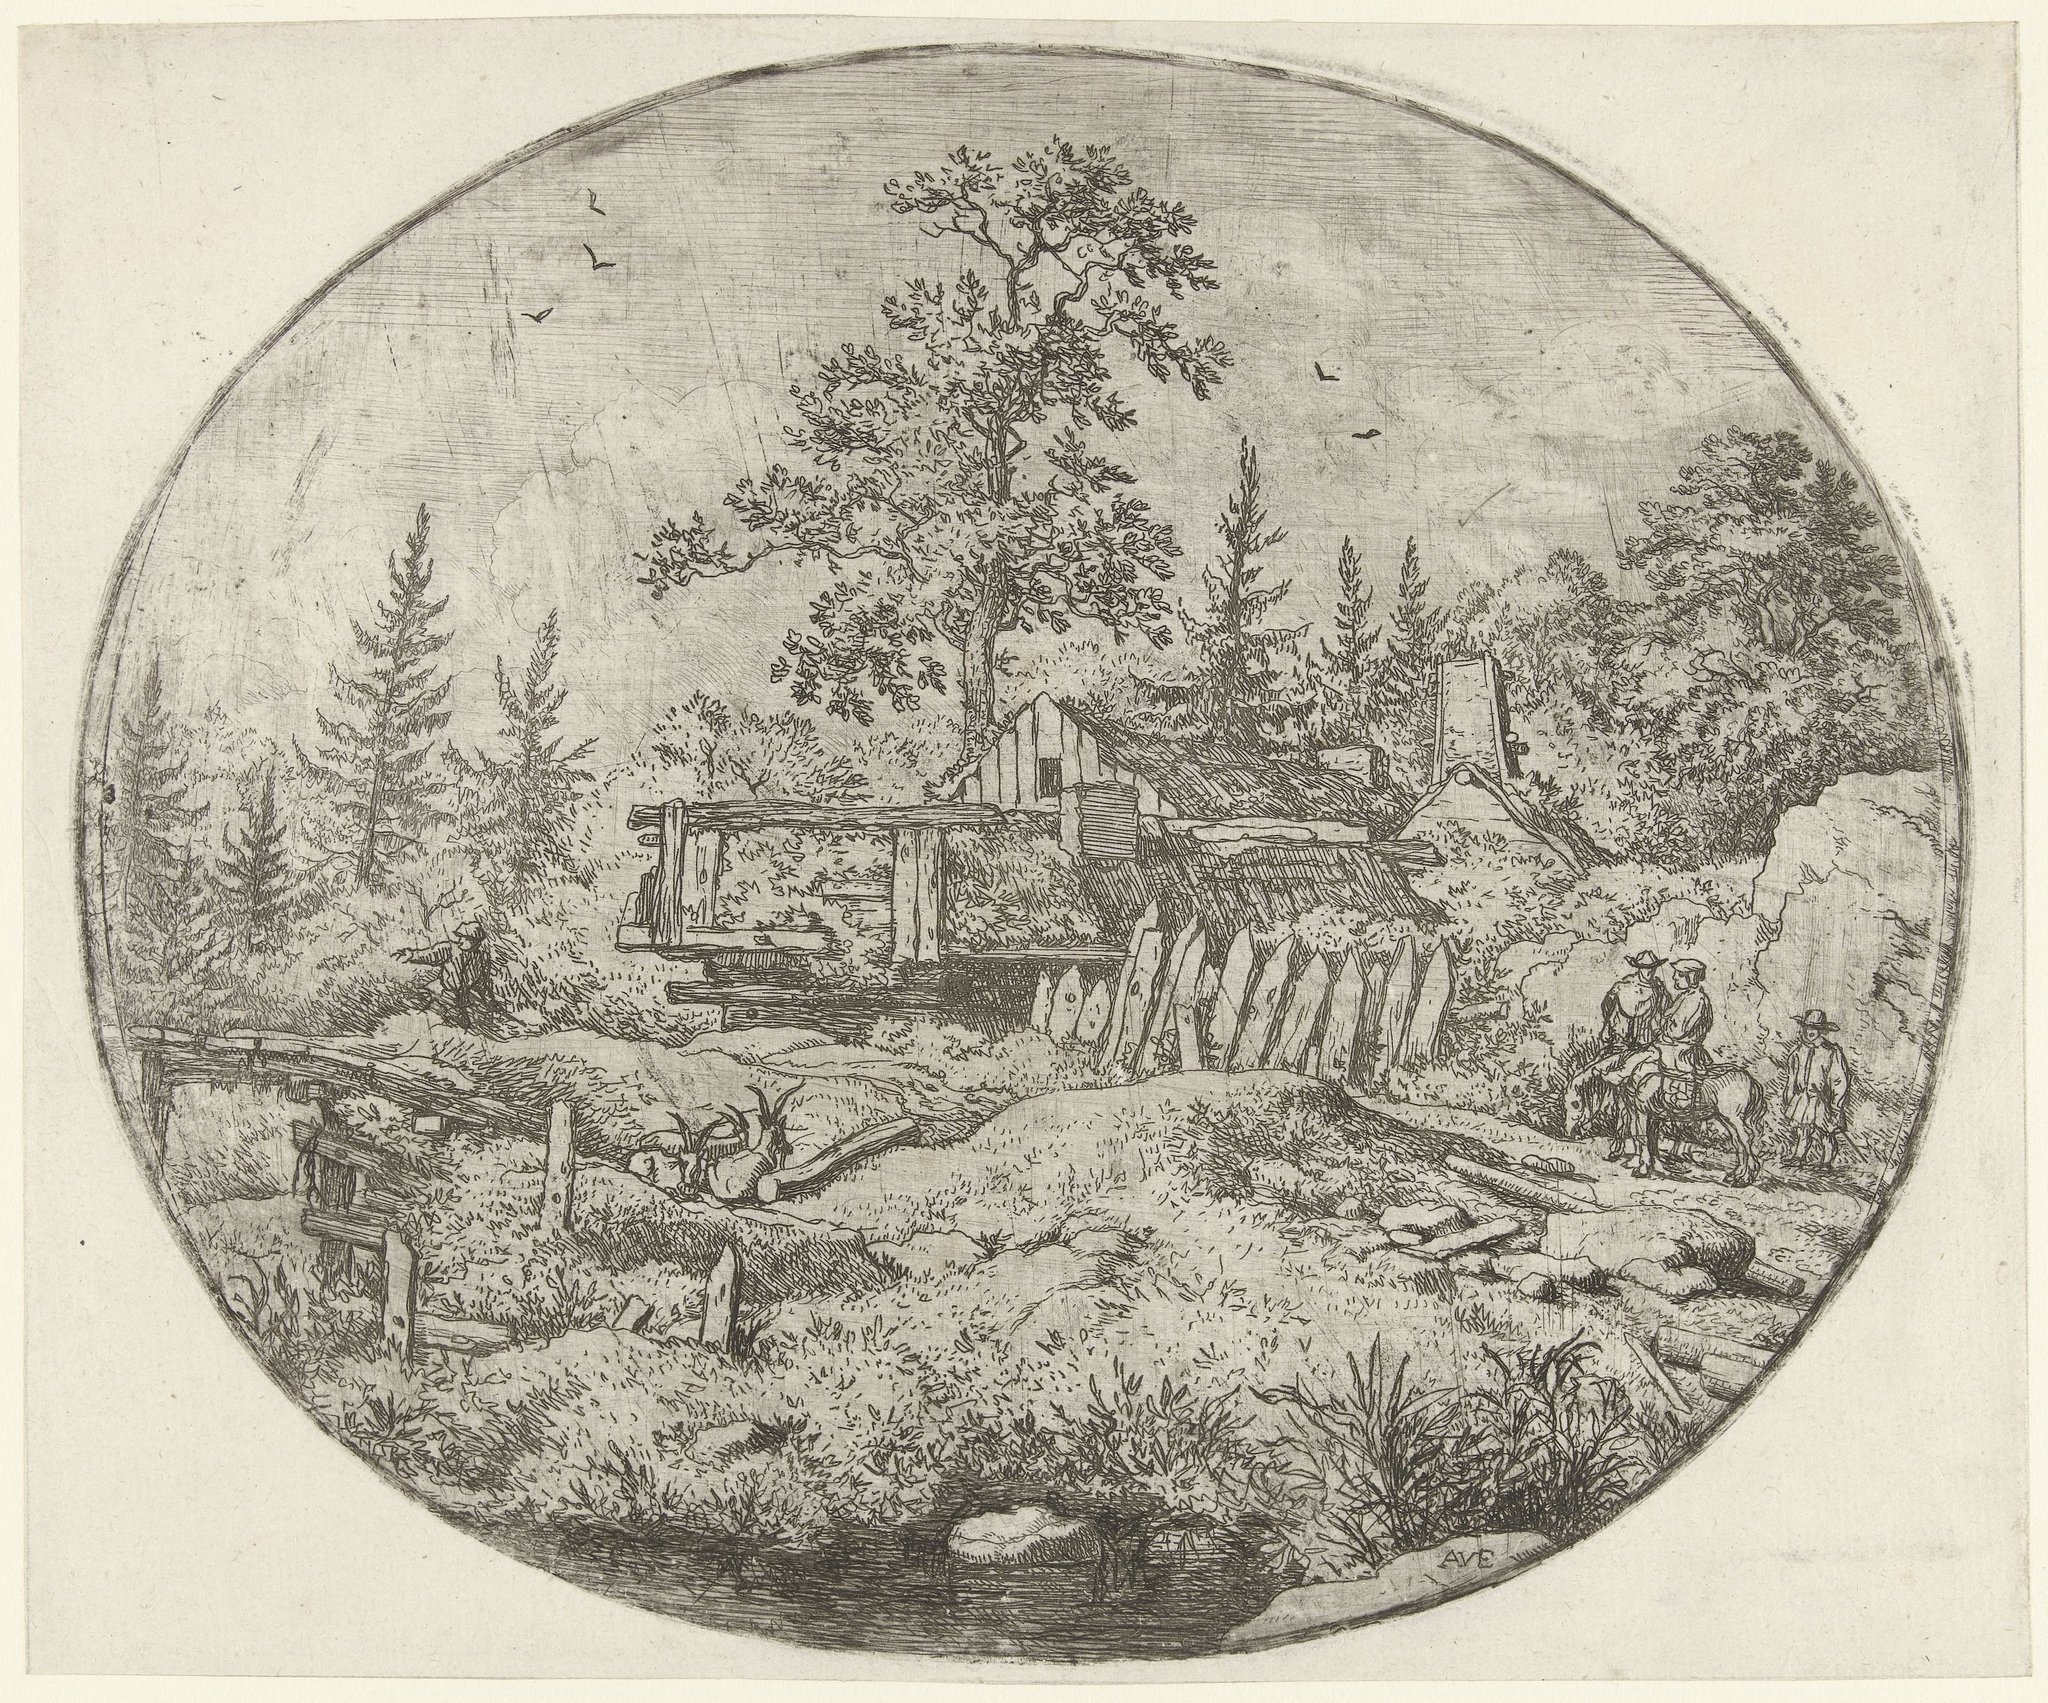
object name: print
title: Landschap met ruiter nabij gehucht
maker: allaert van everdingen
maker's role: draughtsman, painter, print maker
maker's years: 1621-1675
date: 1631-1675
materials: paper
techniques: etching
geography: netherlands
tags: landscapes (+ landscape with figures, staffage)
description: Ovaal landschap met een gehucht van houten gebouwen en een pad waarop een man te paard en twee voetgangers. Verderop bij een brug een vierde man.